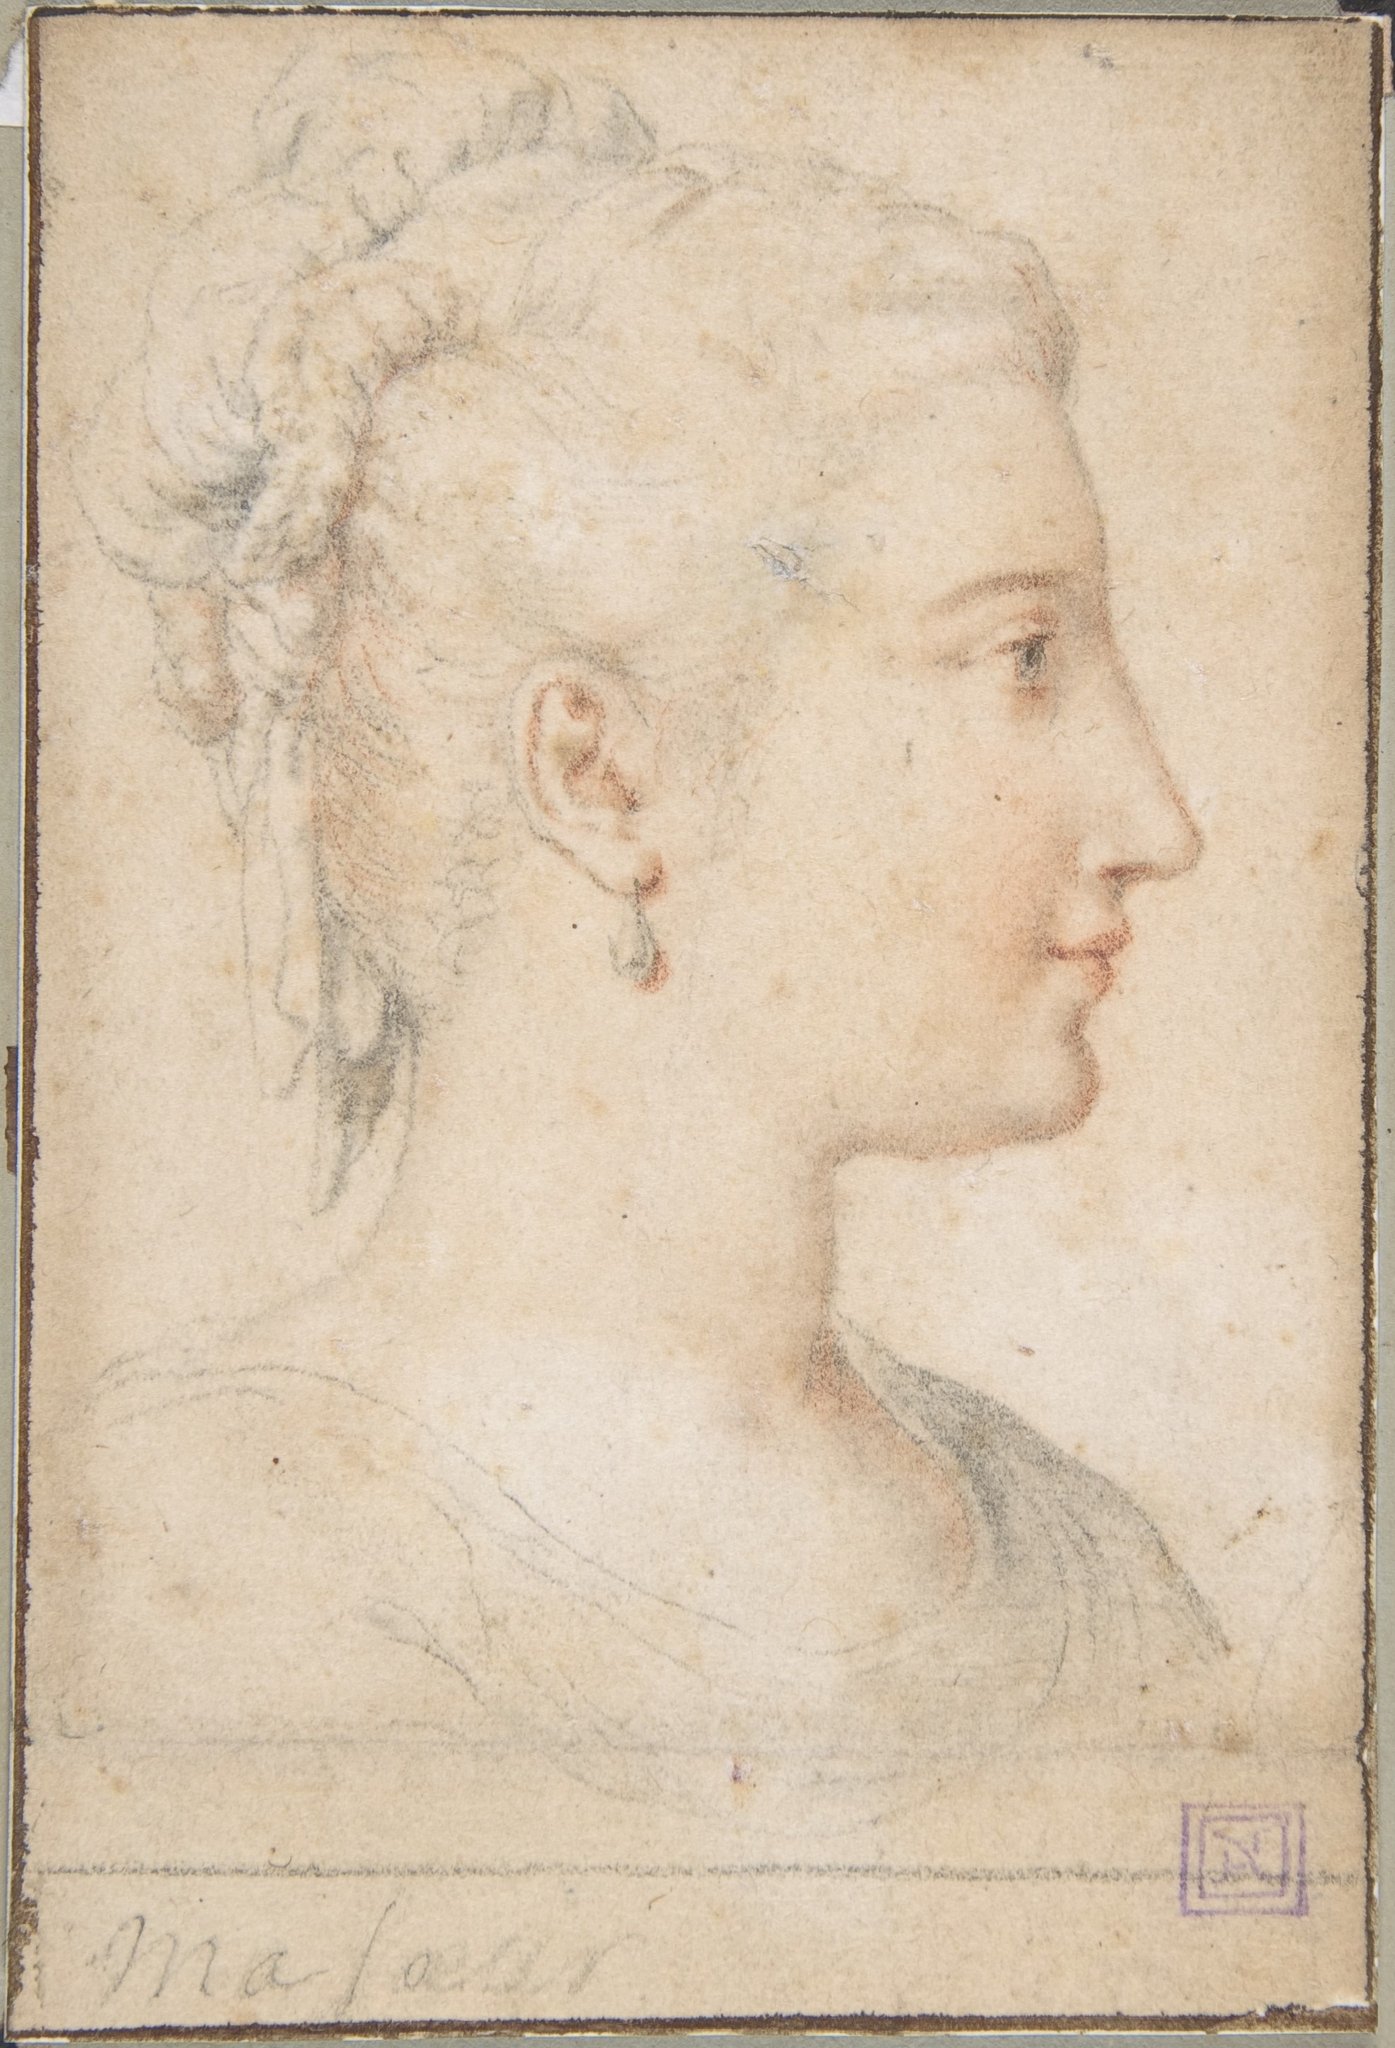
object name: drawing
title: Head of a Woman in Profile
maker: anonymous, french, 16th century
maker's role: artist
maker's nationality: french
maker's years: 1500-1600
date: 1501-1600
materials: chalk, ink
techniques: pen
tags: profiles,women